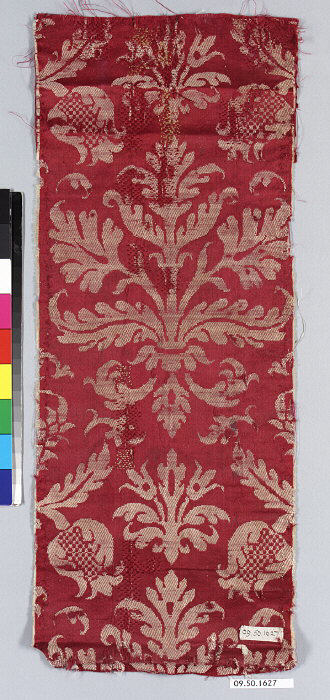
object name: piece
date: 1601-1700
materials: silk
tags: flowers,leaves